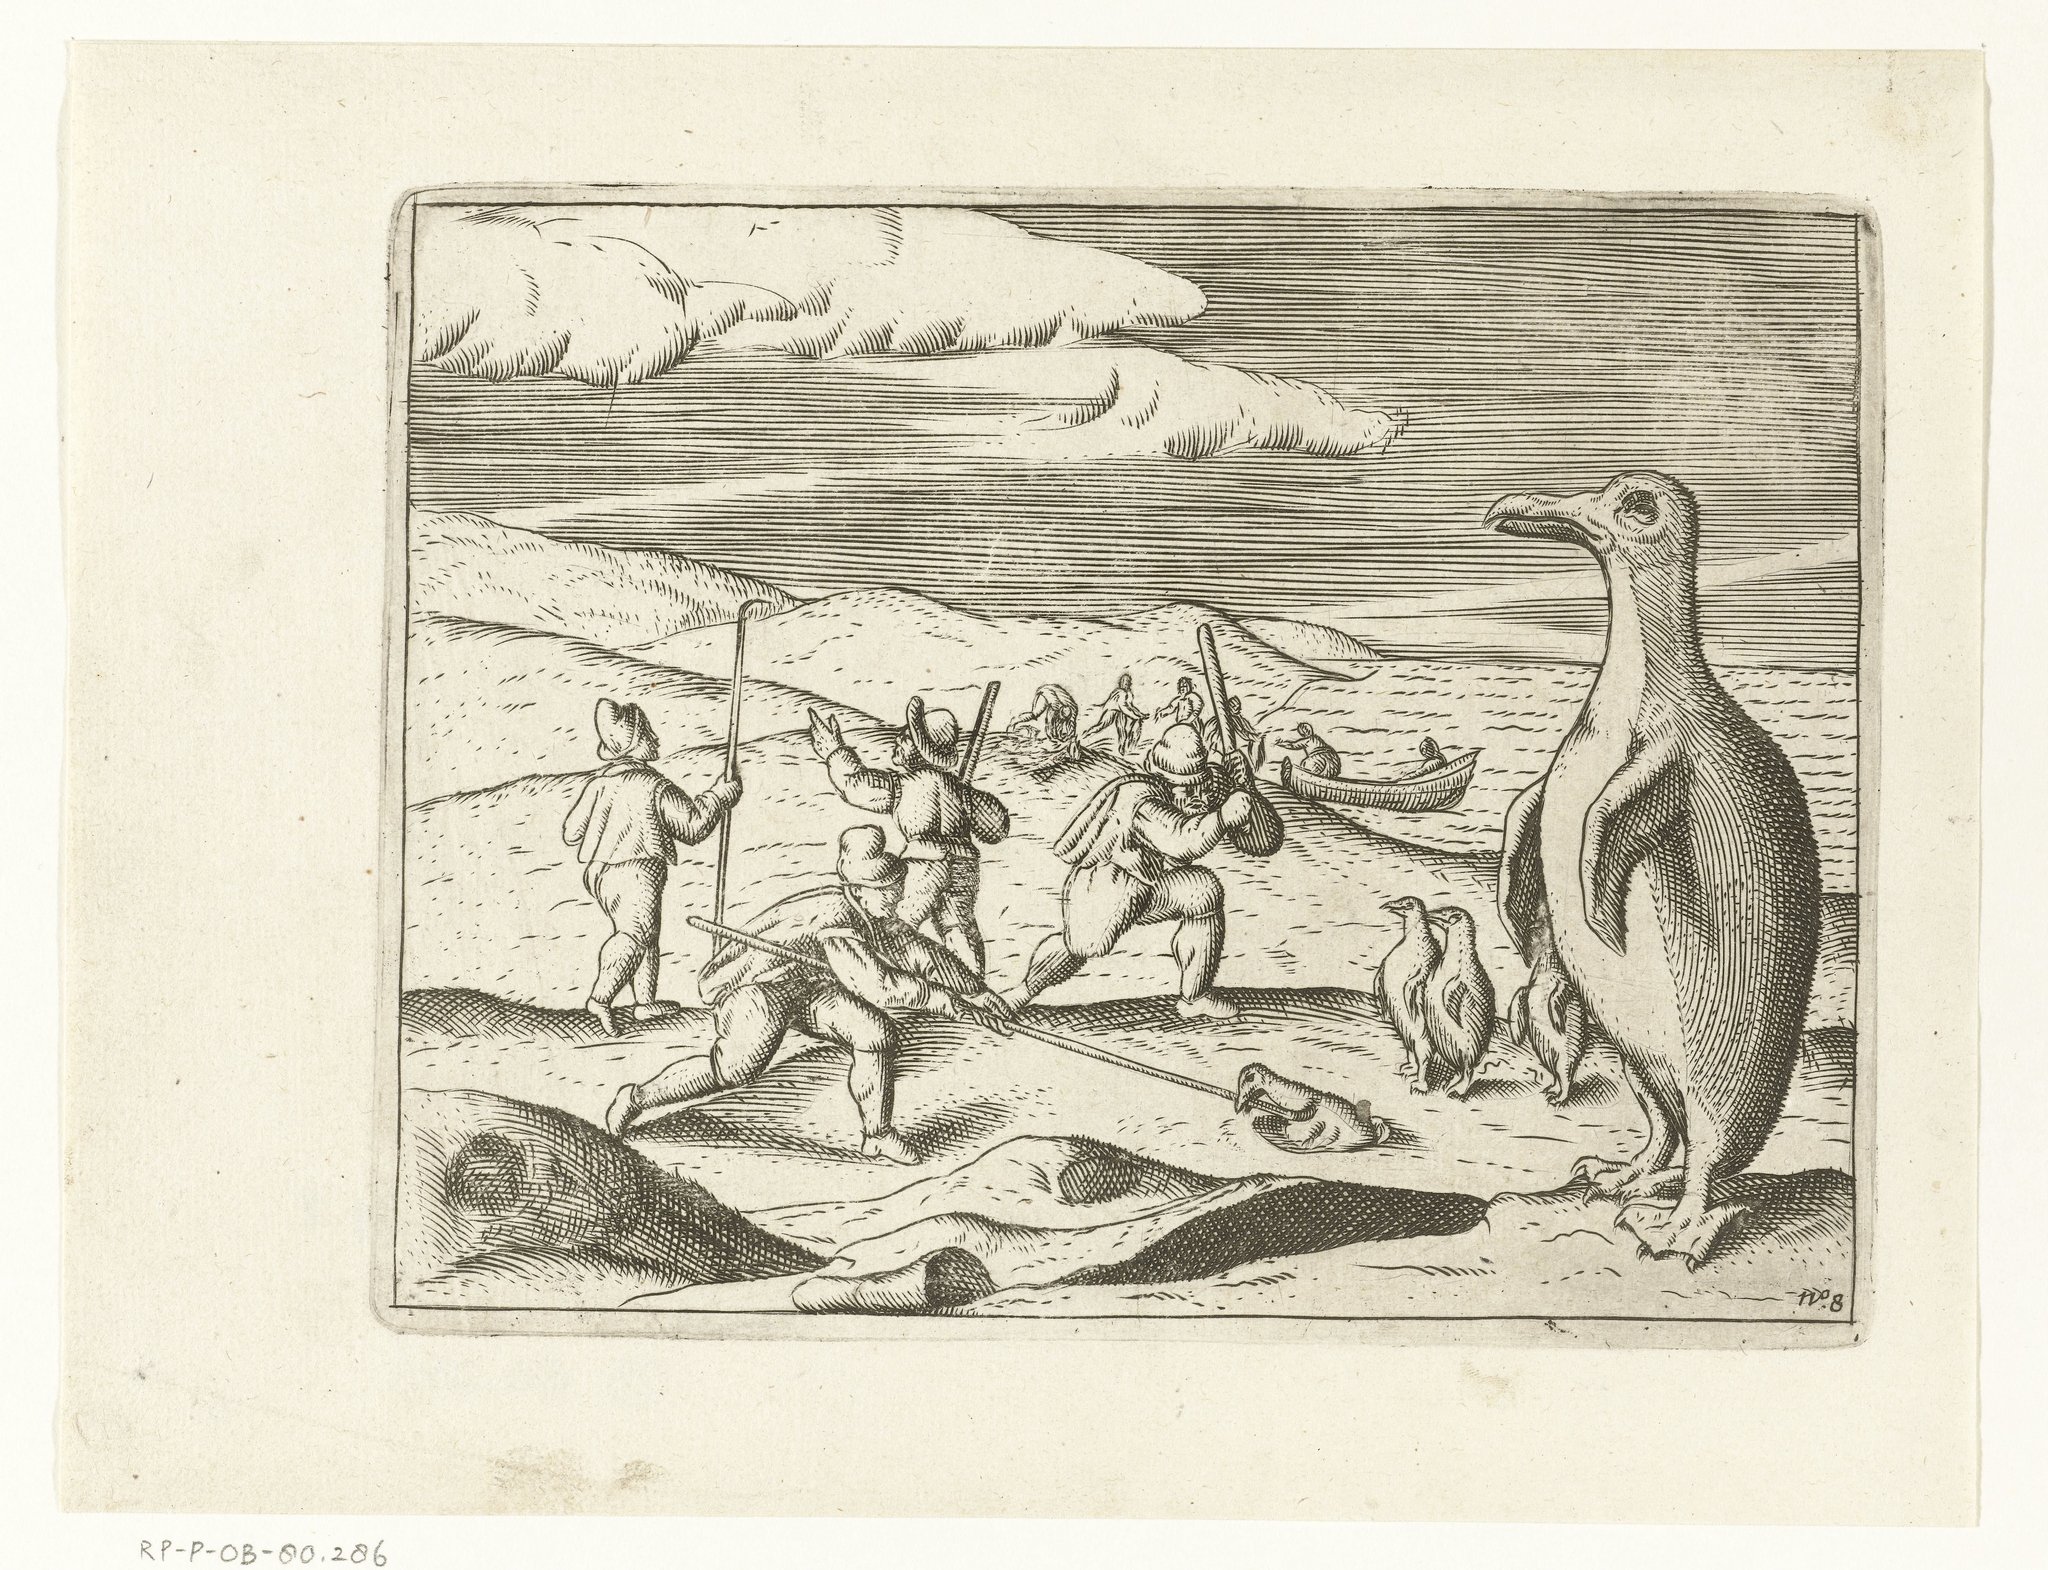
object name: print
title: Jacht op pinguïns, 1600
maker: Anonymous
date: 1617-1619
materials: paper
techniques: engraving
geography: northern netherlands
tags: sri lanka, water-birds: penguin, hunting, chase, landscapes in polar regions, exploration, expedition, voyage of discovery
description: De oorspronkelijke illustraties eerst gebruikt in: Barent Jansz Potgieter, Zacharias Heyns, Wijdtloopigh verhael van tgene de vijf schepen (die int jaer 1598 tot Rotterdam toegherust werden om door de Straet Magellana haren handel te dryven) wedervaren is, tot den 7. September 1599 toe, op welcken dagh capiteyn Sebald de Weert met twee schepen door onweder van de vlote versteken werdt. Ende voort in wat groot gevaer ... hy ... ghelegen heeft, tot dat hy ... weder naar huys heeft moeten keeren plaat, Z. Heyns, Amsterdam 1600. Deze kopieën gebruikt in: Oost-Indische ende West-Indische voyagien, Michiel Colijn, Amsterdam 1619 en later in: Kort ende waerachtigh Verhael van 't gheene seeckere vijf Schepen, van Rotterdam, in 't jaer 1598, den 27 Junij nae de Straet Magaljanes varende, over-ghekomen is. Opgenomen in: I. Commelin, Begin ende voortgangh, van de Vereenighde Nederlantsche Geoctroyeerde Oost-Indische Compagnie, J. Janssonius, Amsterdam 1646. Genummerd: No. 8.